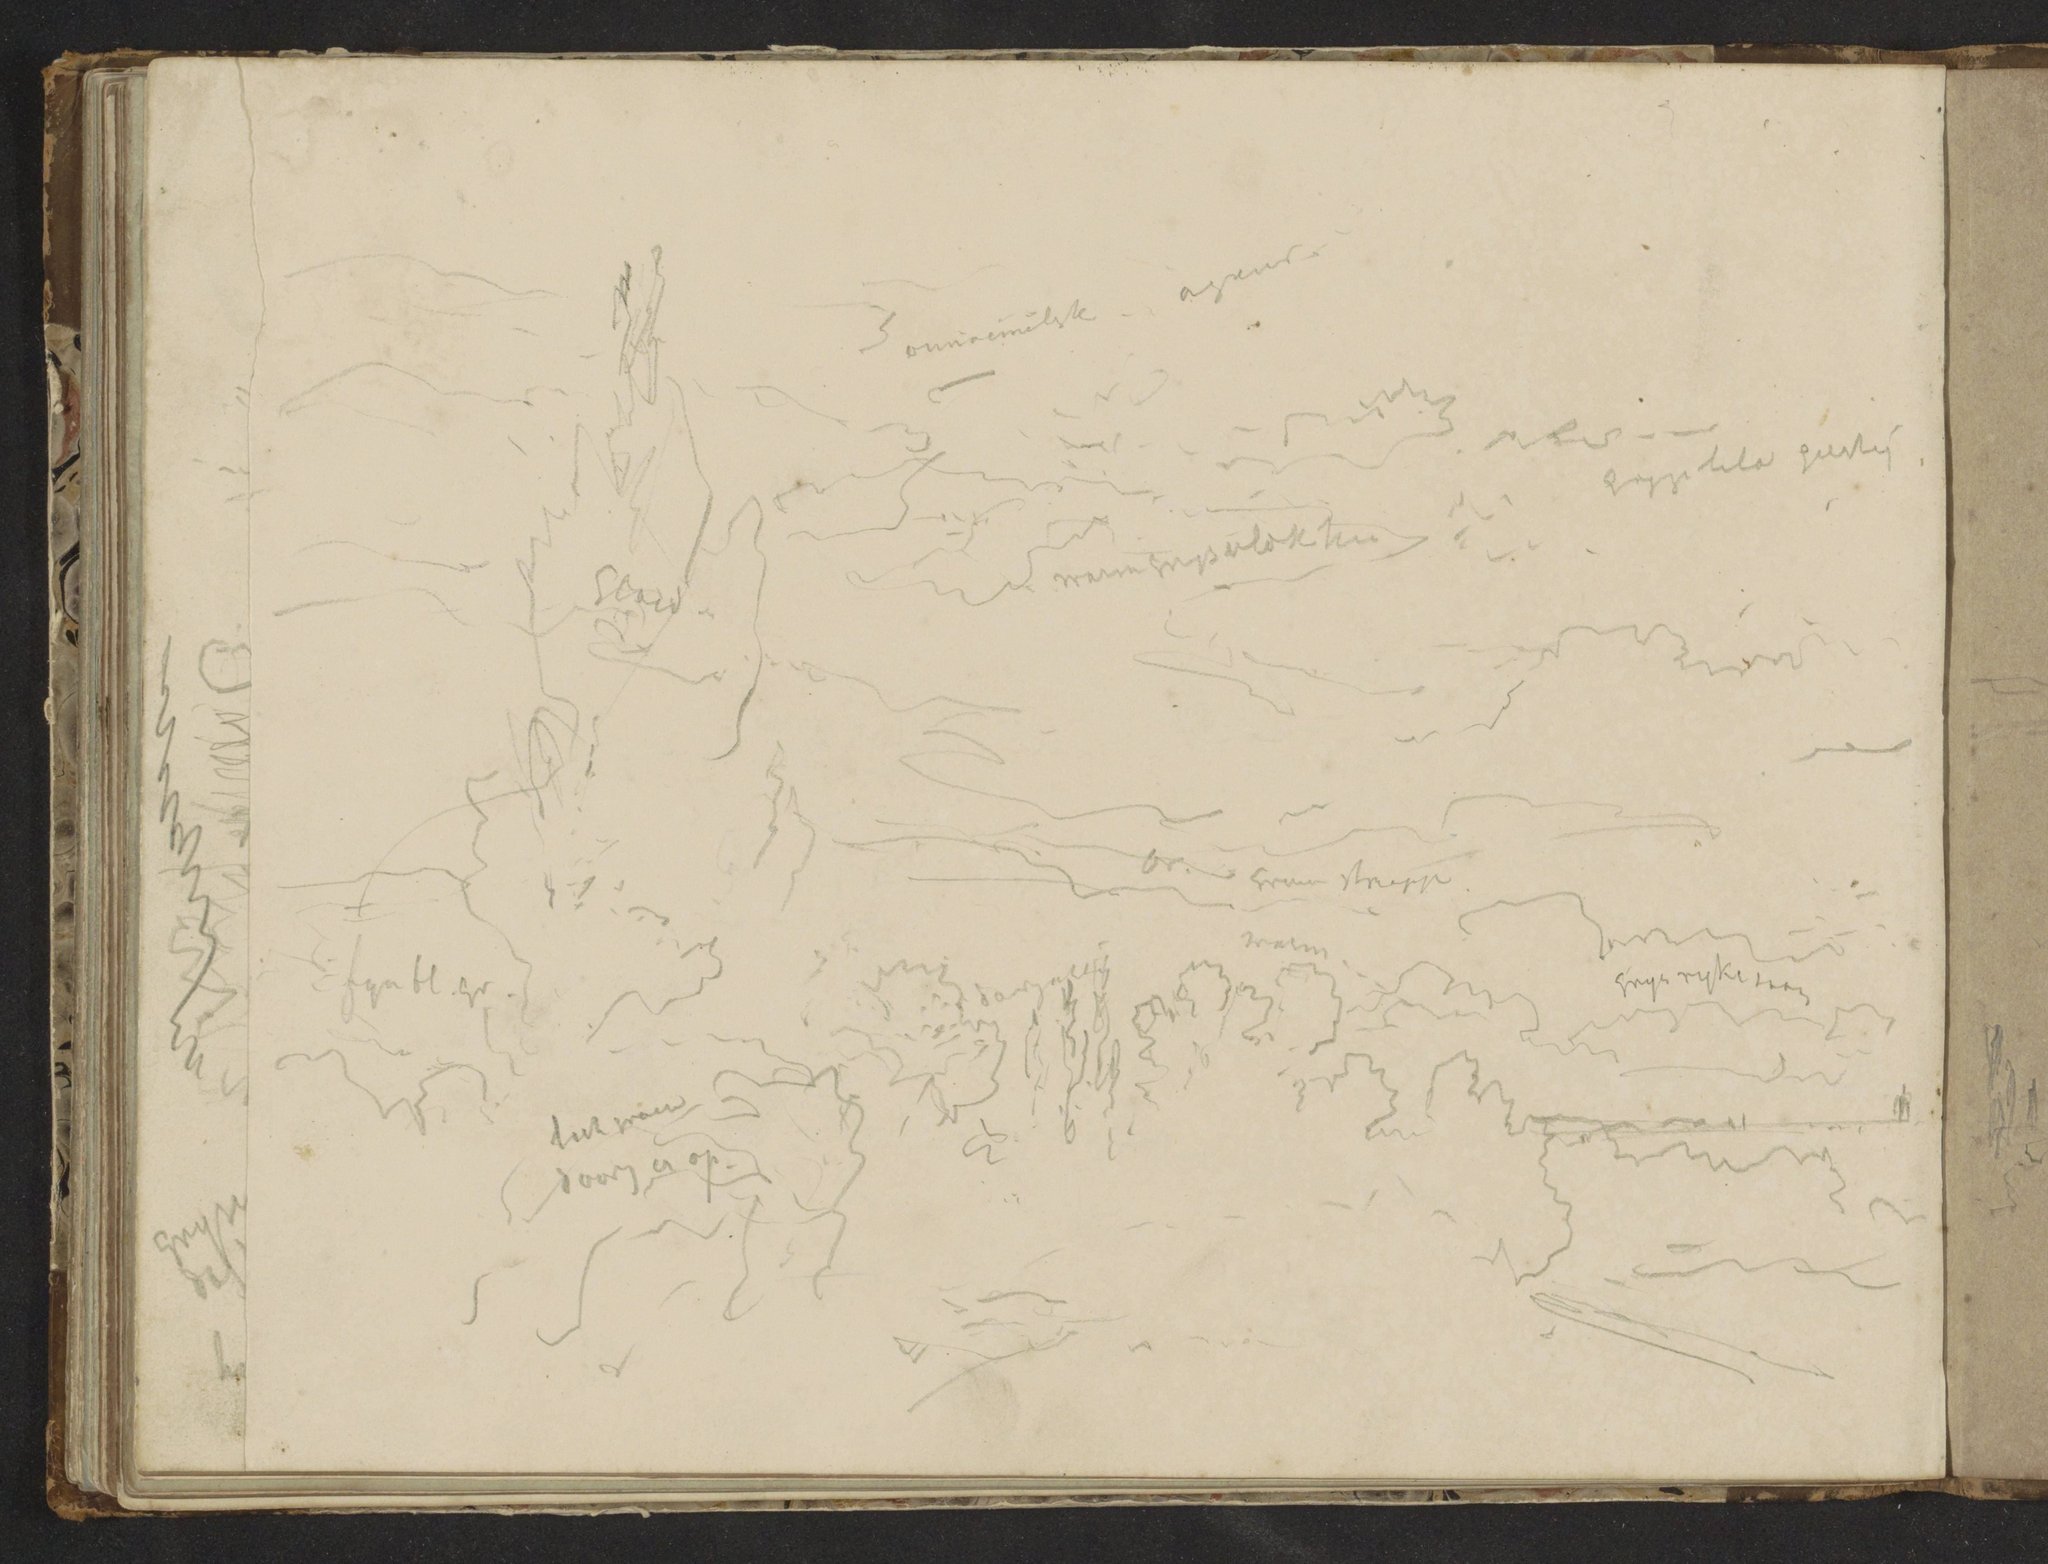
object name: sketchbook leaf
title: Landschap met bomen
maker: johannes tavenraat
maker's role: draughtsman, painter, print maker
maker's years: 1809-1881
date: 1833-1841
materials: paper, pencil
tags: trees, landscapes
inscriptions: kleurnotitie, handgeschreven in potlood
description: Blad 39 verso uit een schetsboek met 41 bladen.